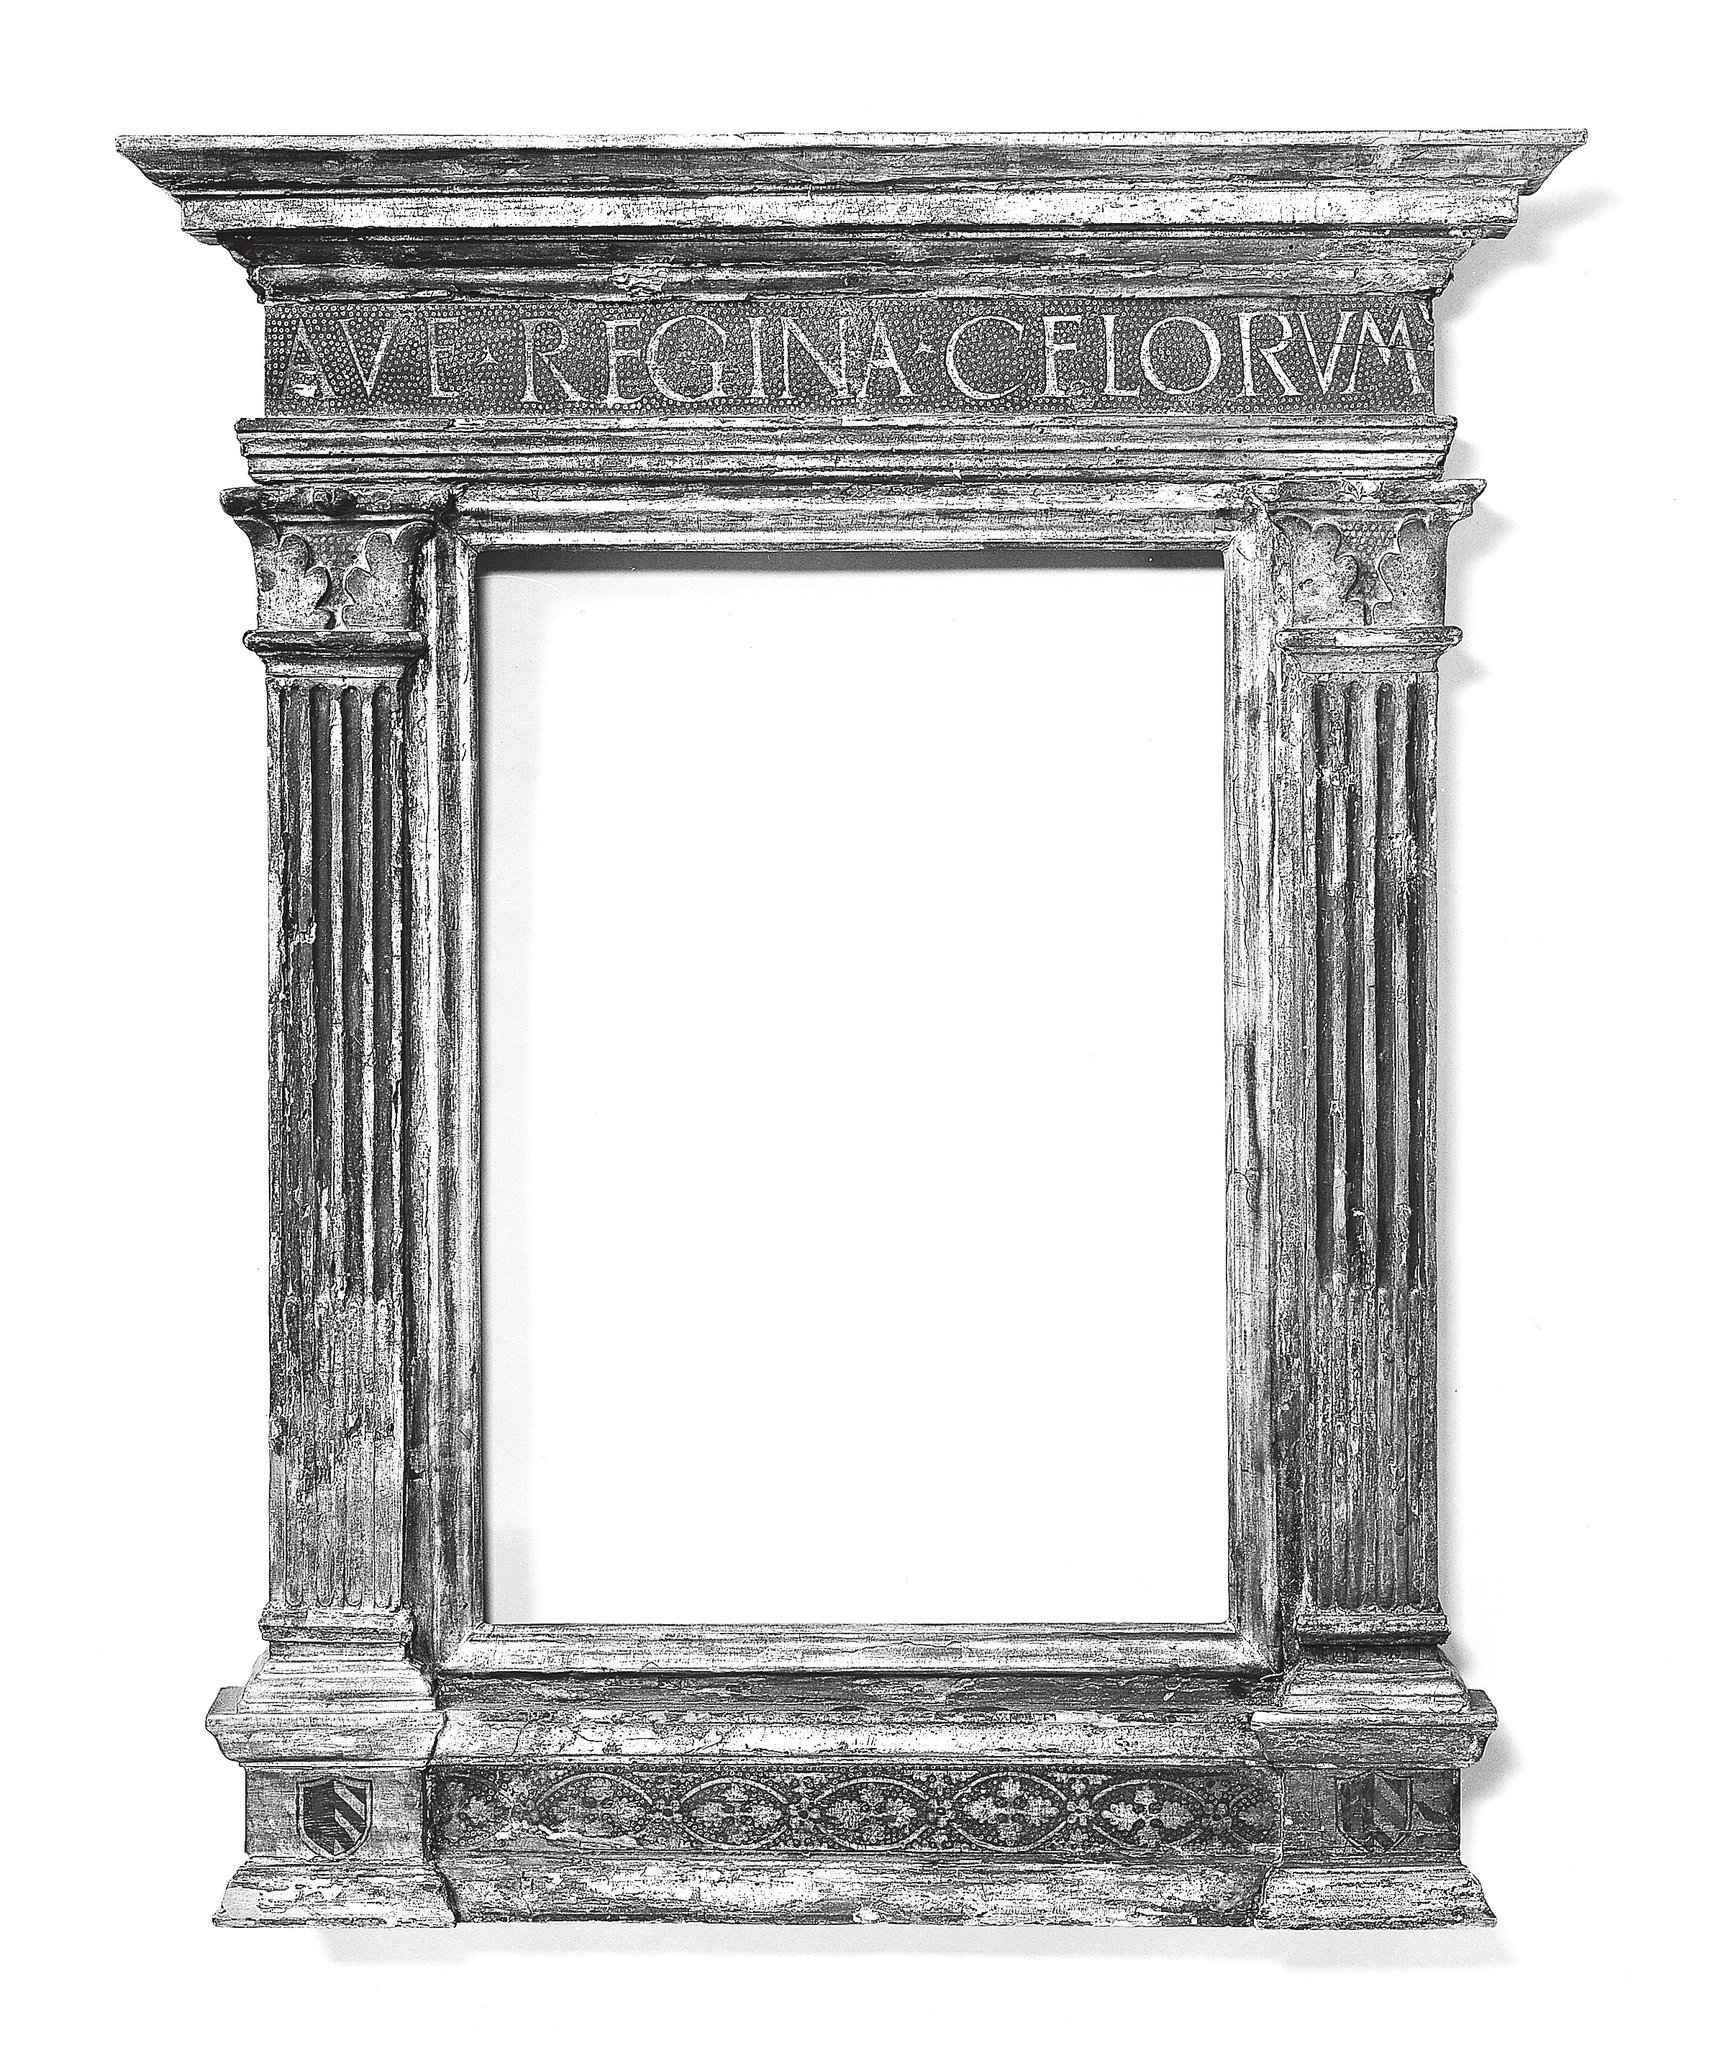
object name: frame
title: Tabernacle frame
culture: italian, tuscany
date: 1485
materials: wood